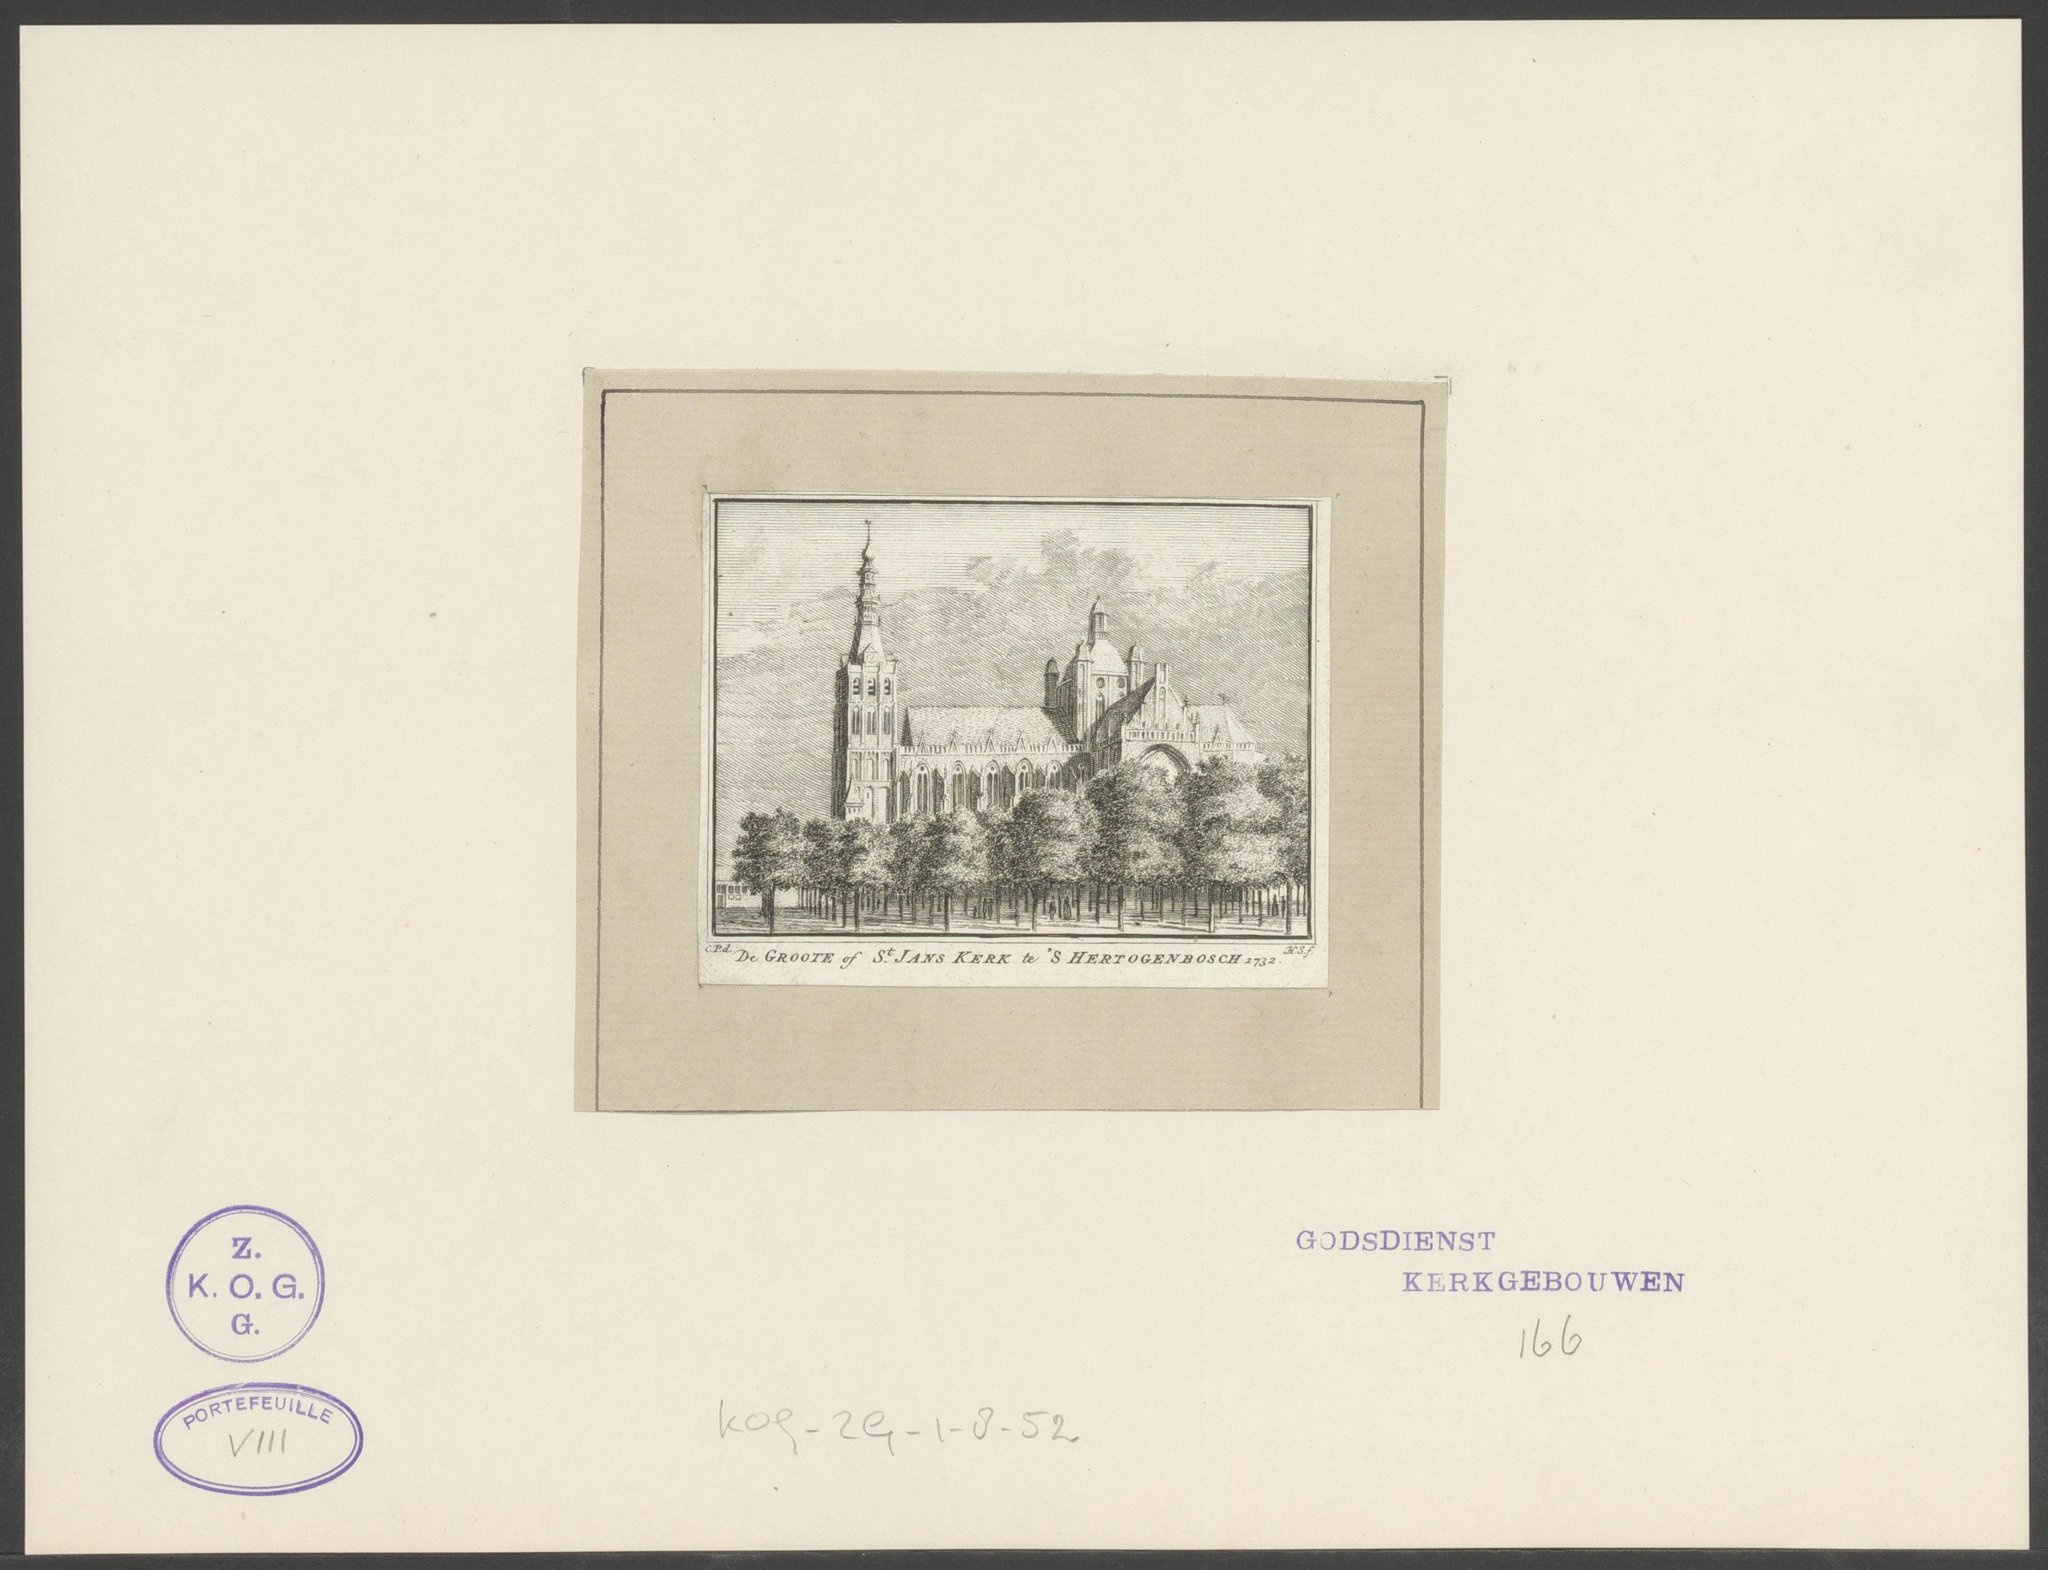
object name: print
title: Gezicht op de Sint-Janskathedraal in 's-Hertogenbosch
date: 1746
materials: paper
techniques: engraving, etching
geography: netherlands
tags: church (exterior)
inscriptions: collector's mark: Lugt 1641, collector's mark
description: Gezicht op de Sint-Janskathedraal in 's-Hertogenbosch, in het jaar 1732. Onderwerpsrubrieken binnen de Atlas Zeden en Gewoonten: Kerk en kerkwezen & Armwezen en liefdadige instellingen; Kerkgebouwen elders. F-L.